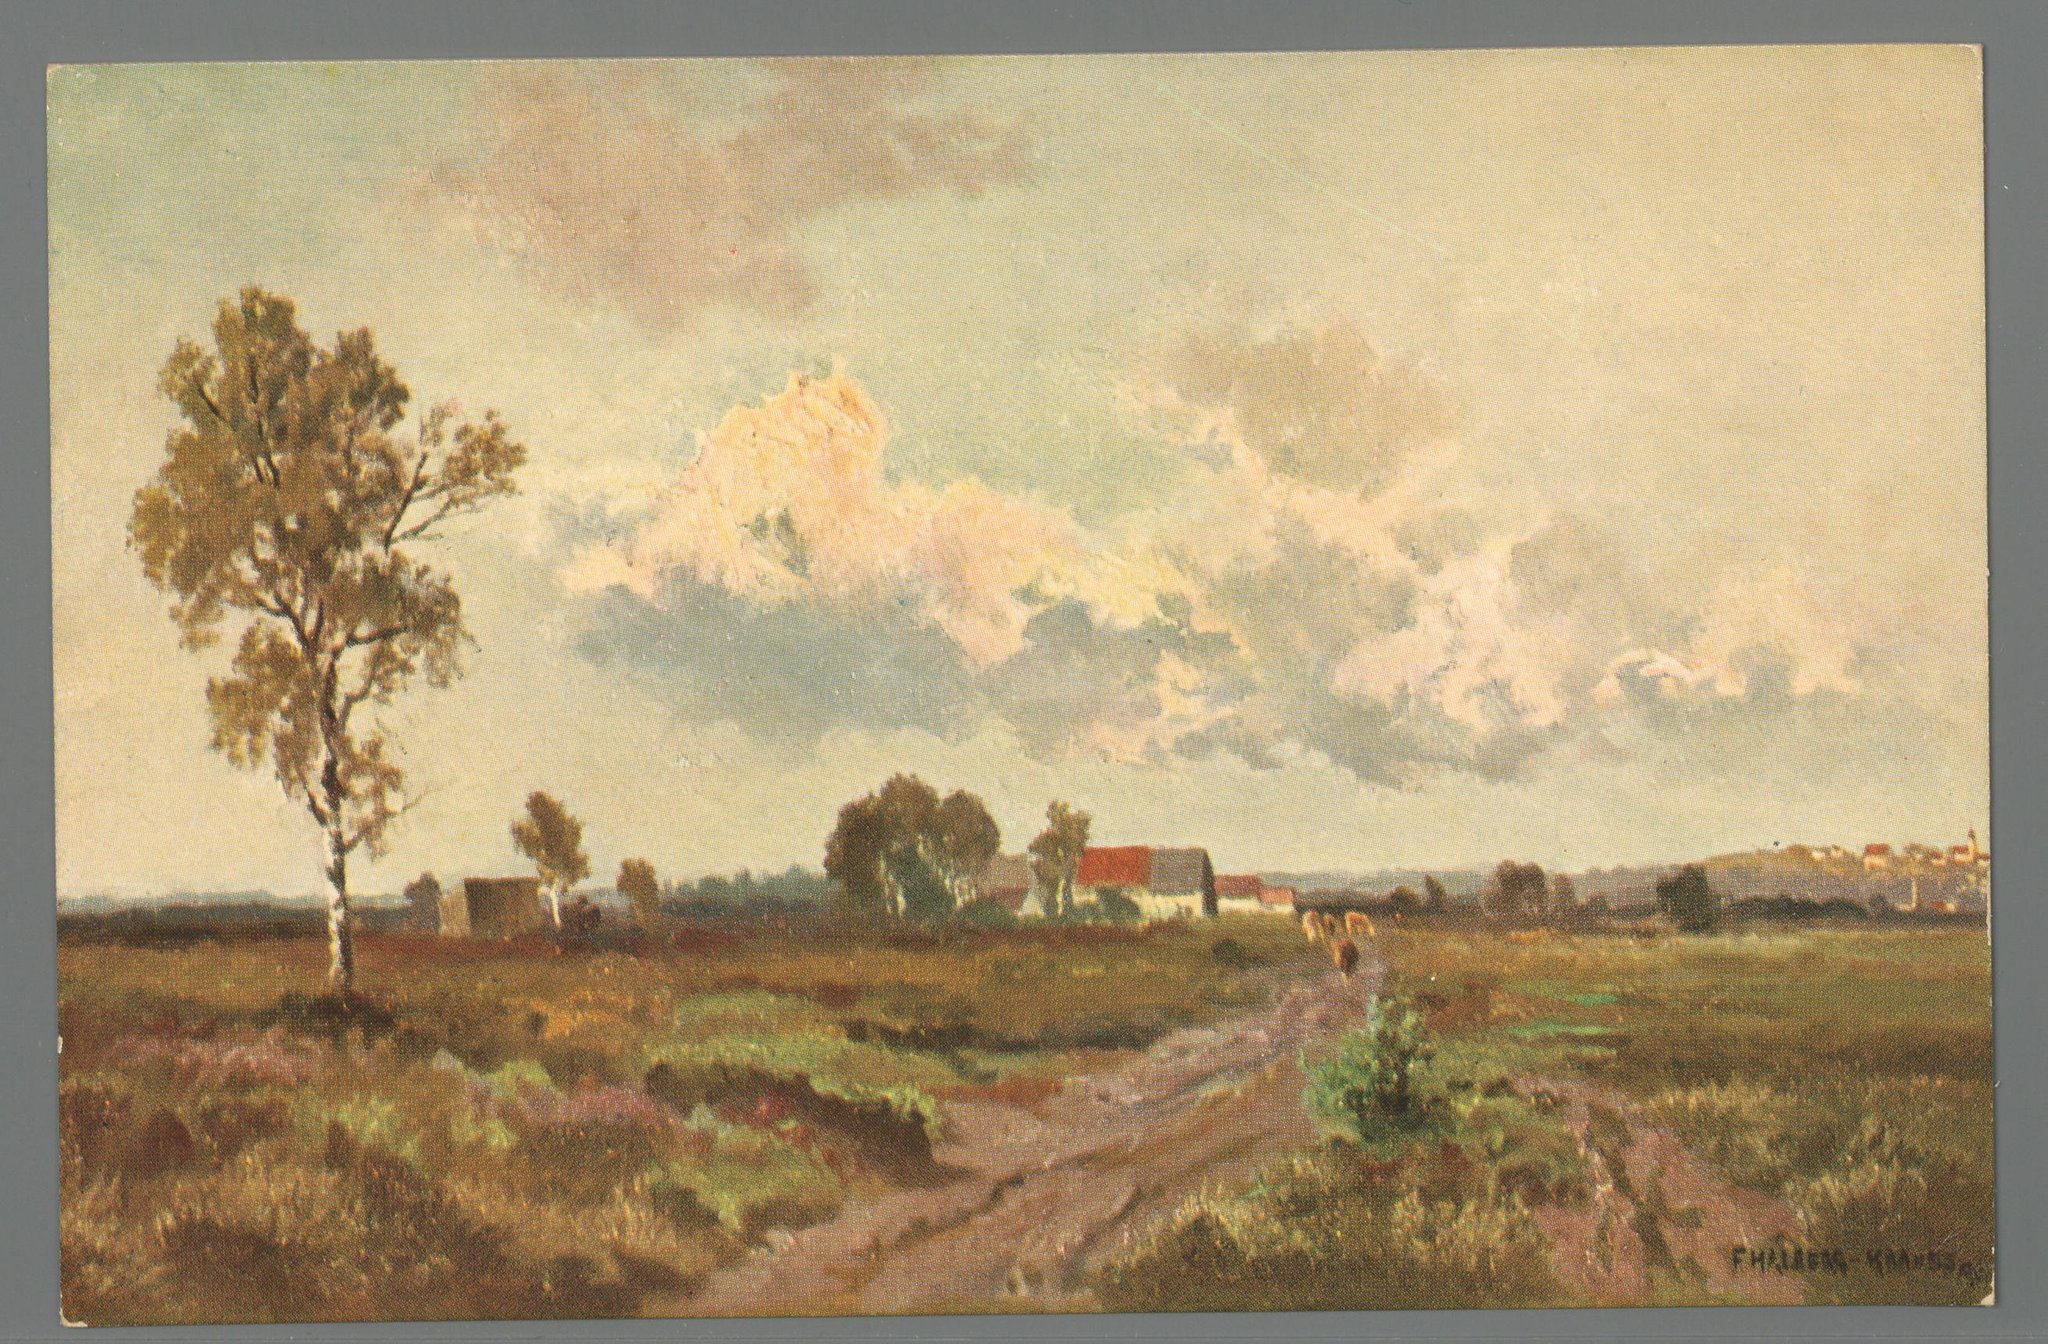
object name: photomechanical print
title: Langens Künstler-Karten Serie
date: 1905-1930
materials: cardboard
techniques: color autotype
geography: munich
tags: farm or solitary house in landscape